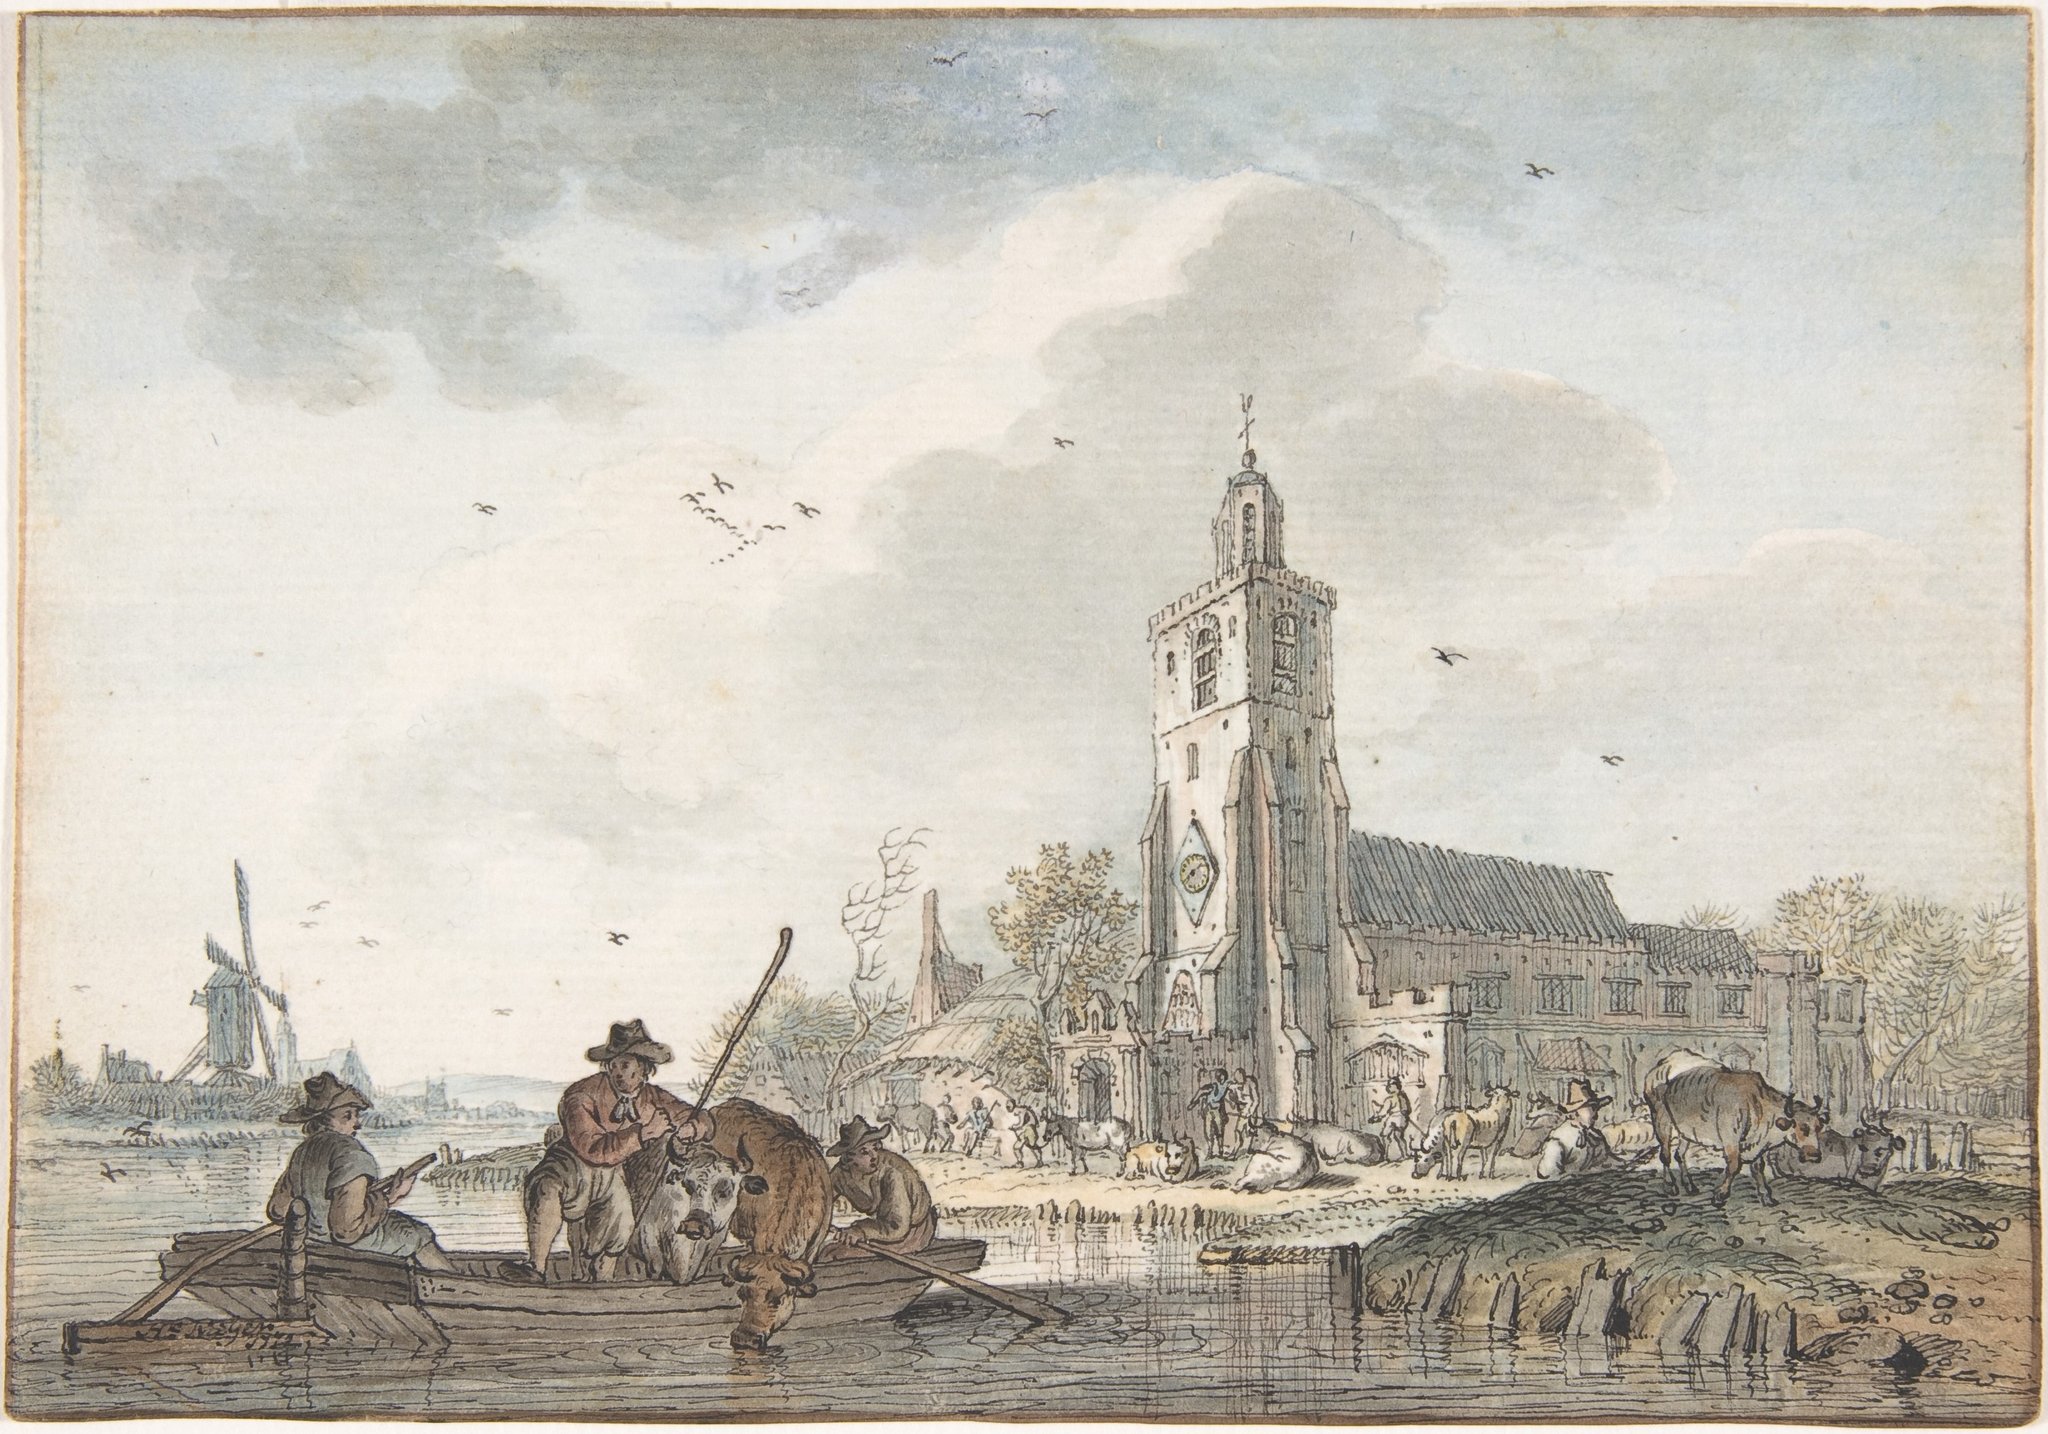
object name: drawing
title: April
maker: hendrik meijer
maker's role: artist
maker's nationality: dutch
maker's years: 1744-1793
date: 1772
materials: chalk, ink, watercolor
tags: buildings,men,cows,boats